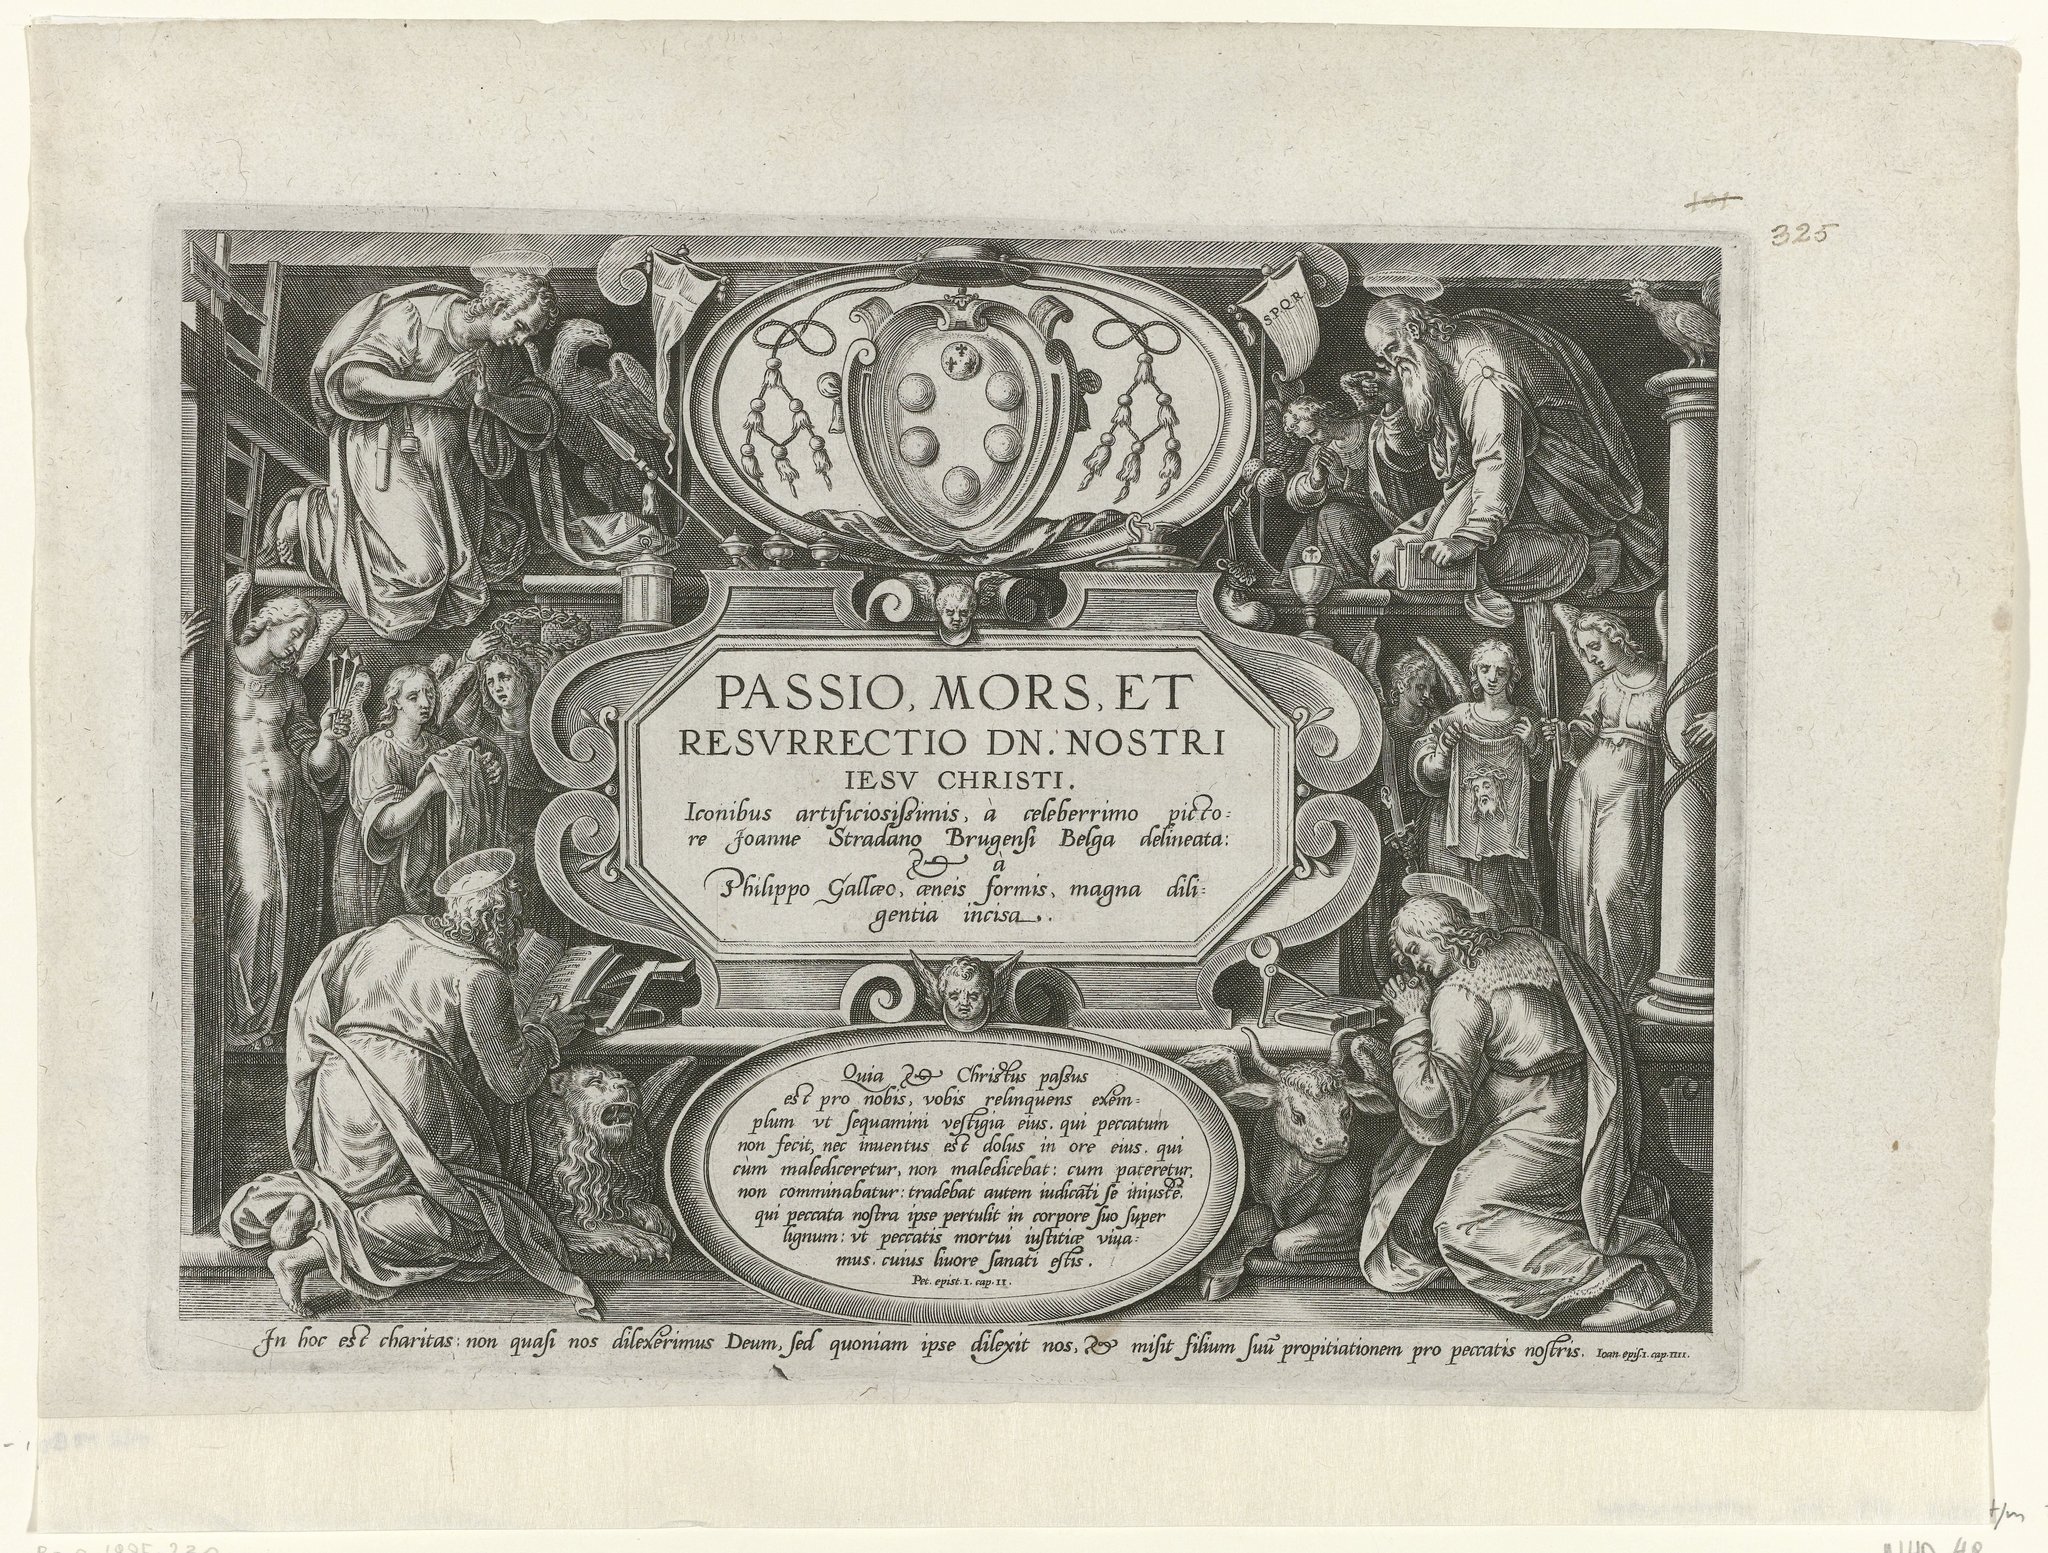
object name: print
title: Passio, mors et resvrrection dn. Nostri Iesv Christ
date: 1585-1586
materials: paper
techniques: engraving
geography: antwerp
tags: evangelists, usually with books or scrolls (not in biblical context), single instruments of the passion, title-page, the four symbols of the evangelists, 'the apocalyptic beasts', armorial bearing, heraldry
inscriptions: watermark: Briquet 309, number: ‘325’, collector's mark: Lugt 2228, collector's mark: Lugt 2760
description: In een octagonale lijst de titel van de serie. Daarboven het wapenschild van Fernando De' Medici. Onder de titel een cartouche met een dedicatie. Naast de titel de werktuigen van de passie. In de vier hoeken van de prent een van de vier evangelisten. De prent heeft een Latijns onderschrift en maakt deel uit van een serie over het passie, door en wederopstanding van Christus.